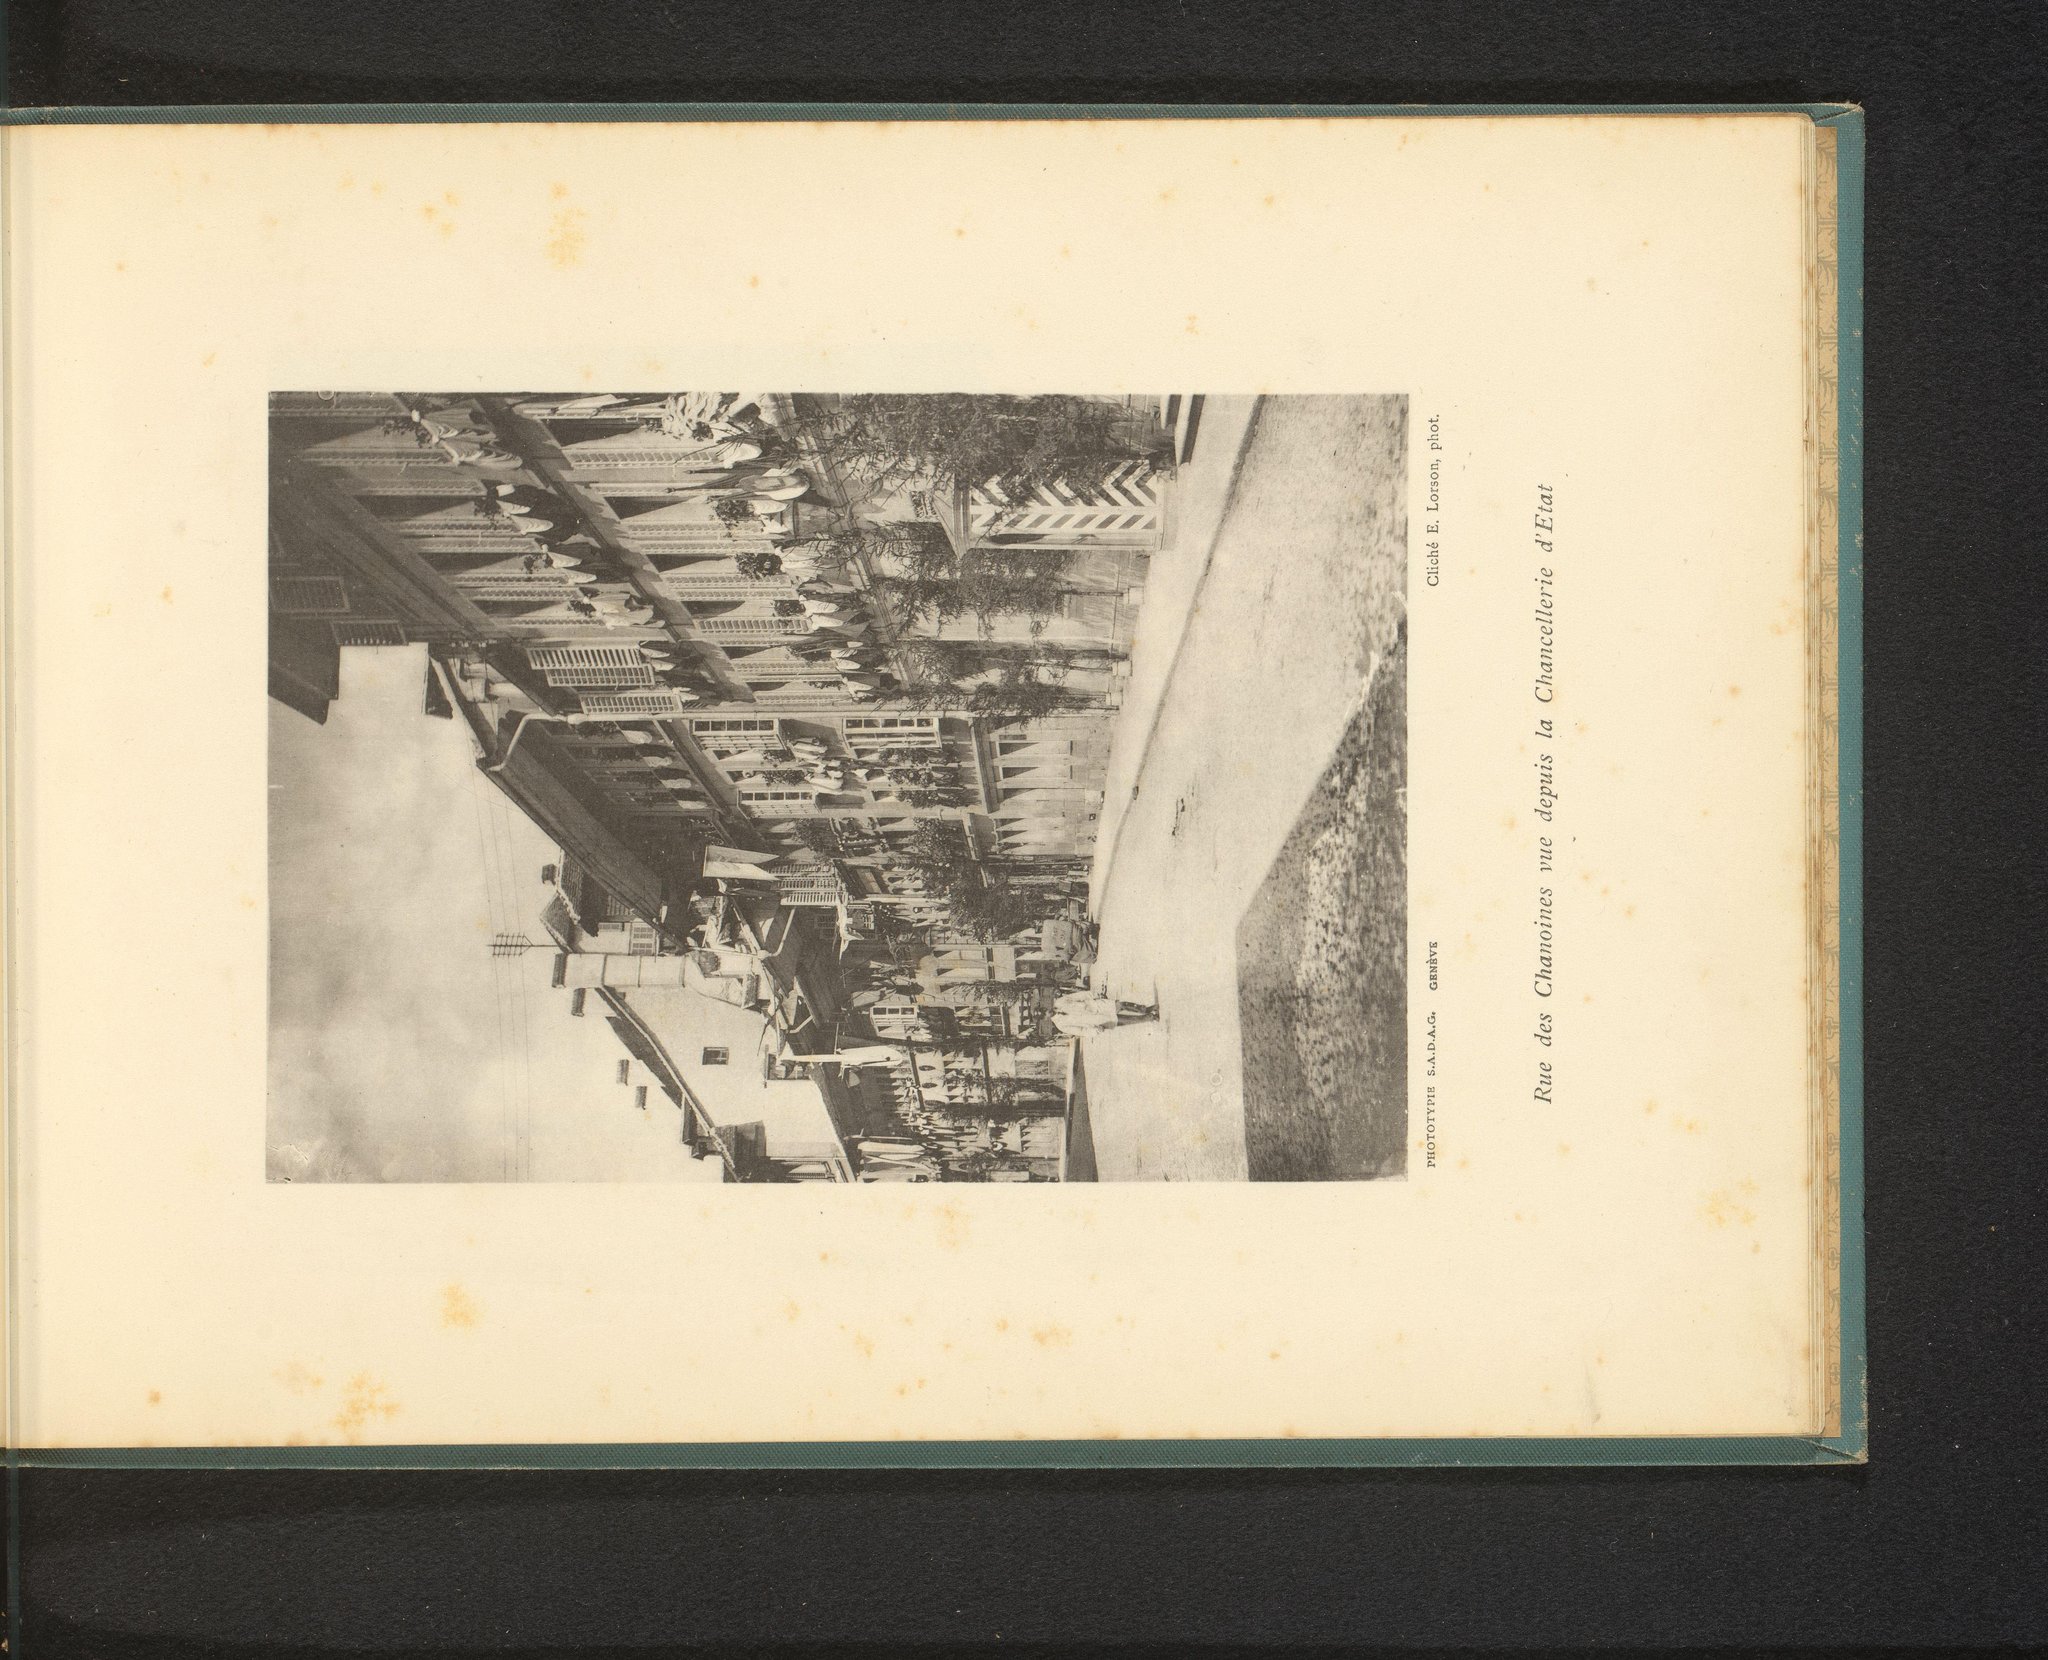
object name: photomechanical print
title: Gezicht op de Rue des Chanoines in Fribourg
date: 1897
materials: paper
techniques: photograph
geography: geneva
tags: street